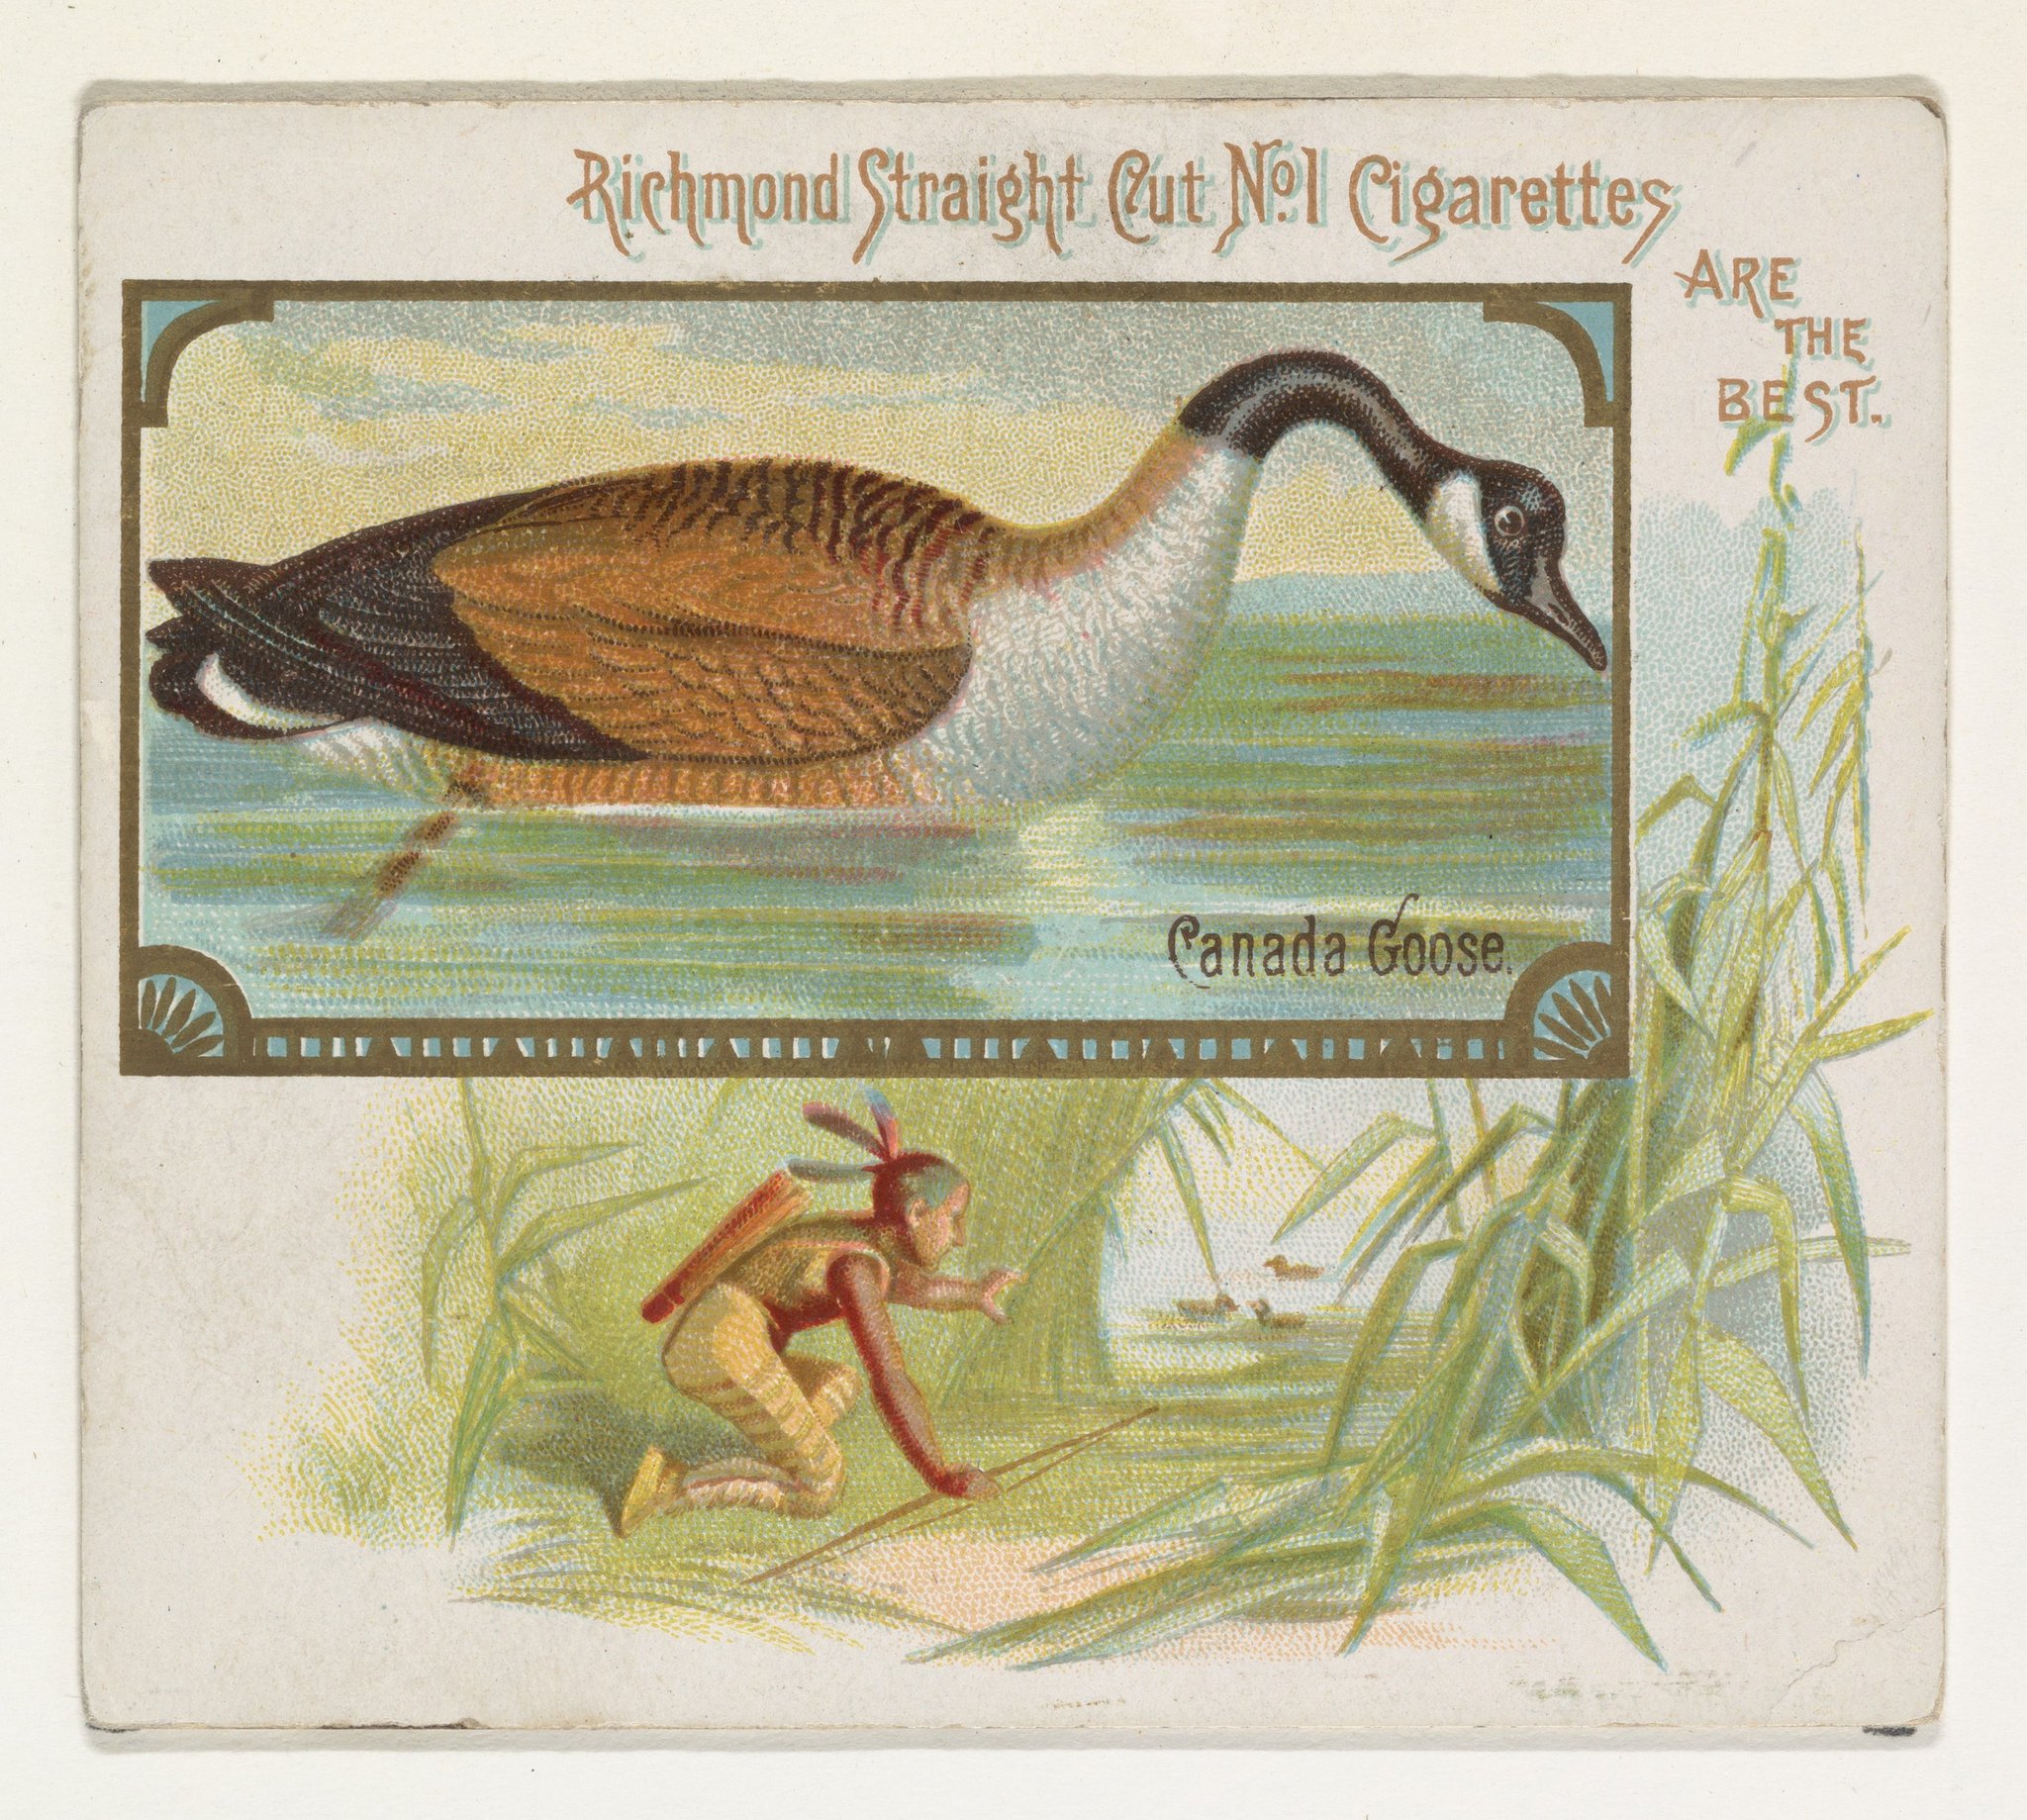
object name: print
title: Canada Goose, from the Game Birds series (N40) for Allen & Ginter Cigarettes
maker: allen & ginter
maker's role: publisher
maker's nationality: american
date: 1888-1890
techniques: color lithograph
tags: birds